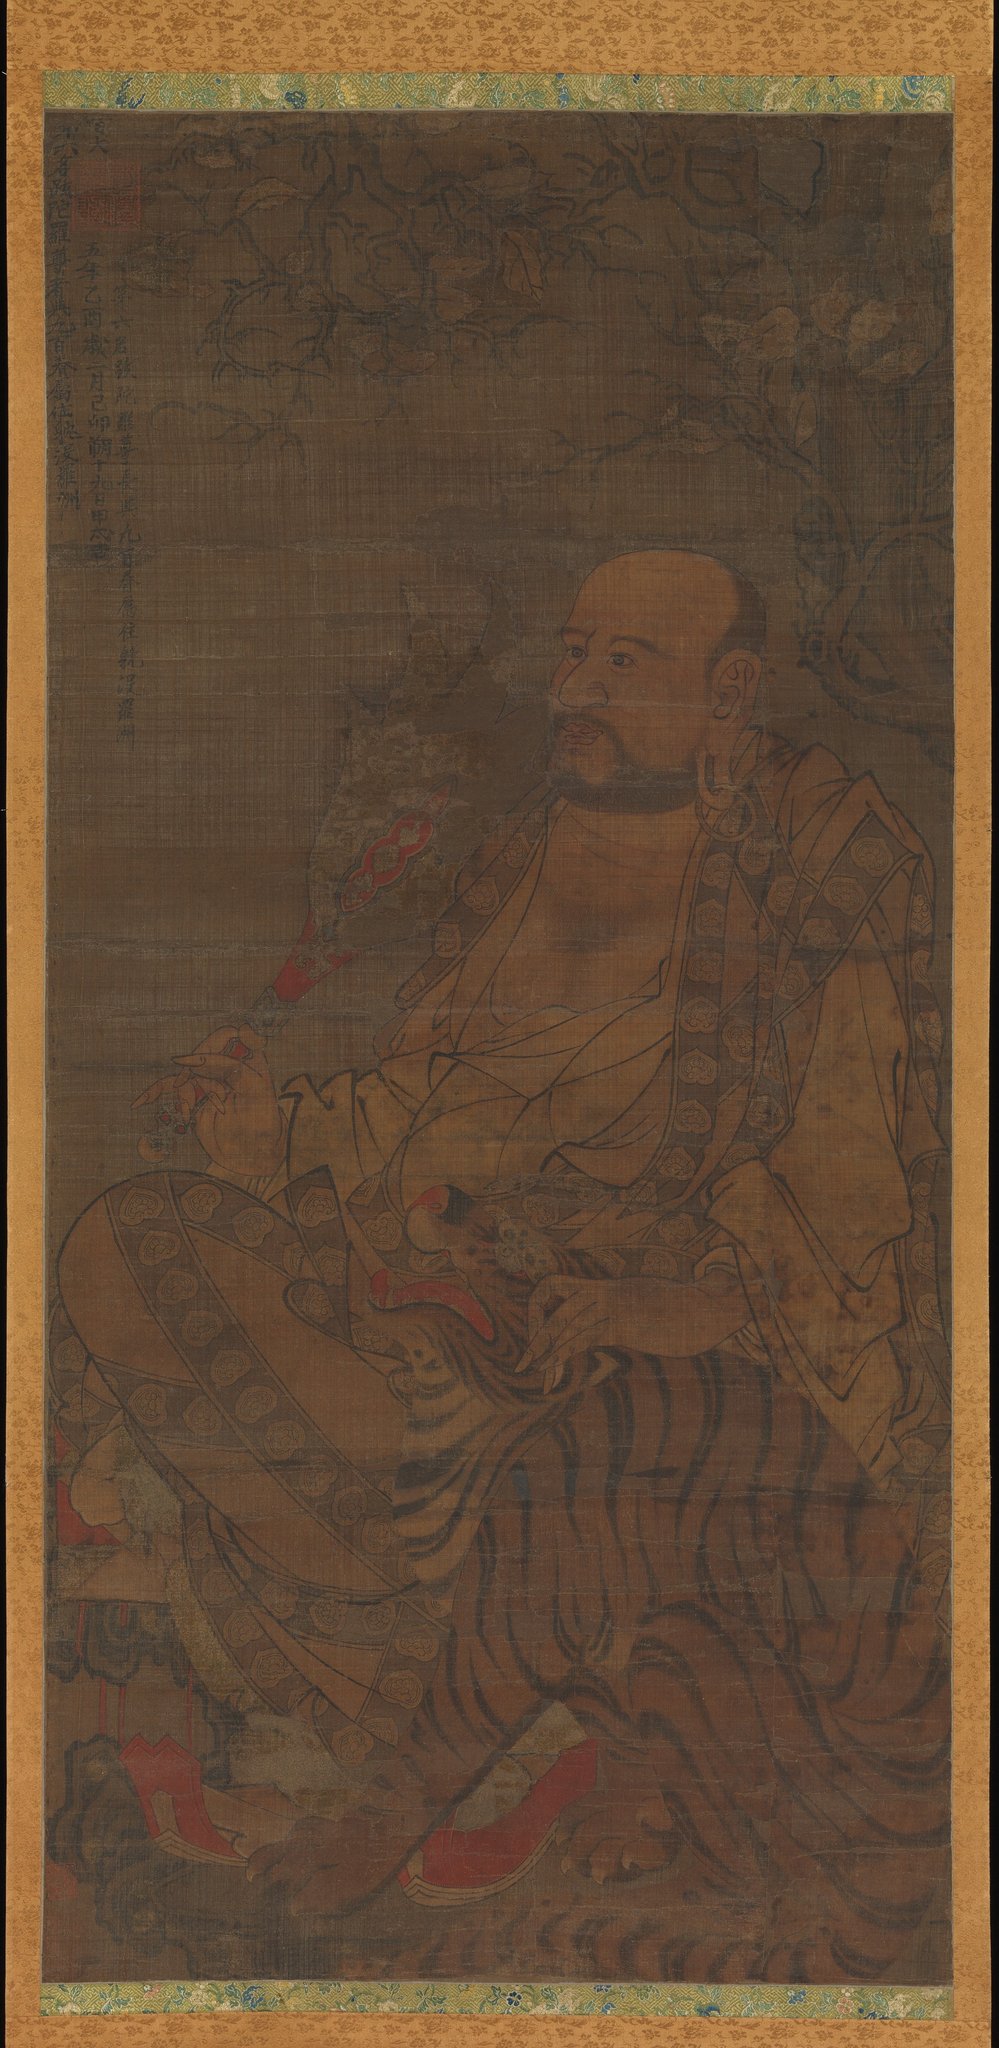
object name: hanging scroll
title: Bhadra, The Sixth Luohan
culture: chinese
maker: unidentified artist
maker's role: artist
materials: ink, silk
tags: men,tigers